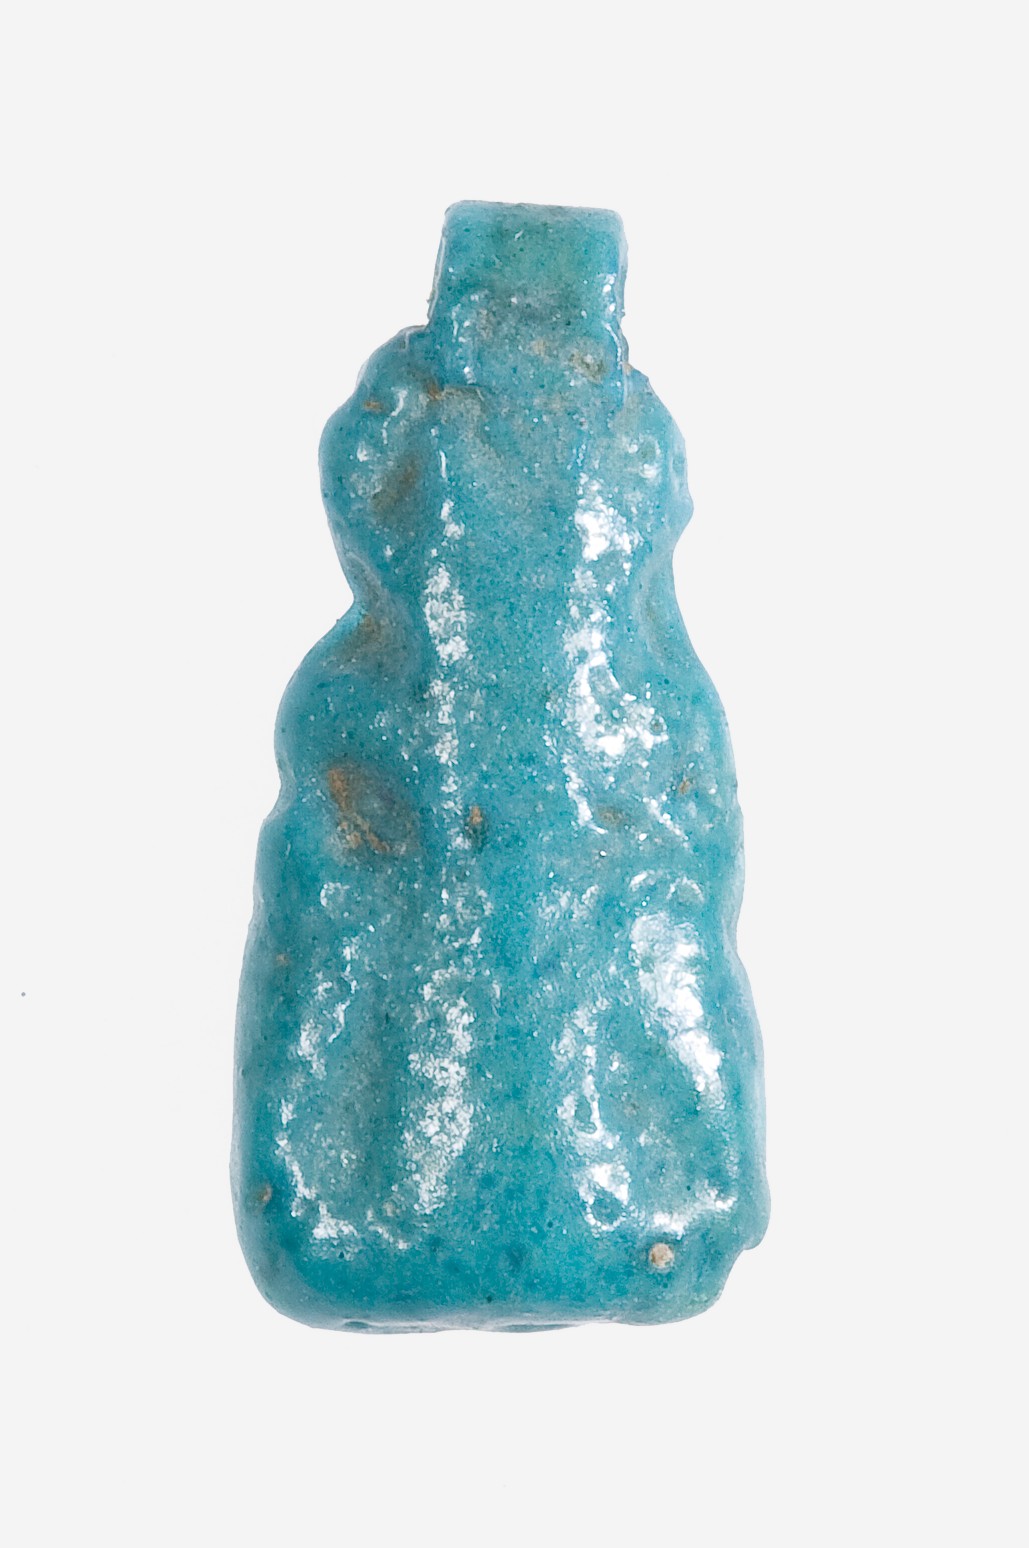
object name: pendant, lily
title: Indeterminate Goddess Pendant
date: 1390-1352 BCE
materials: faience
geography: egypt